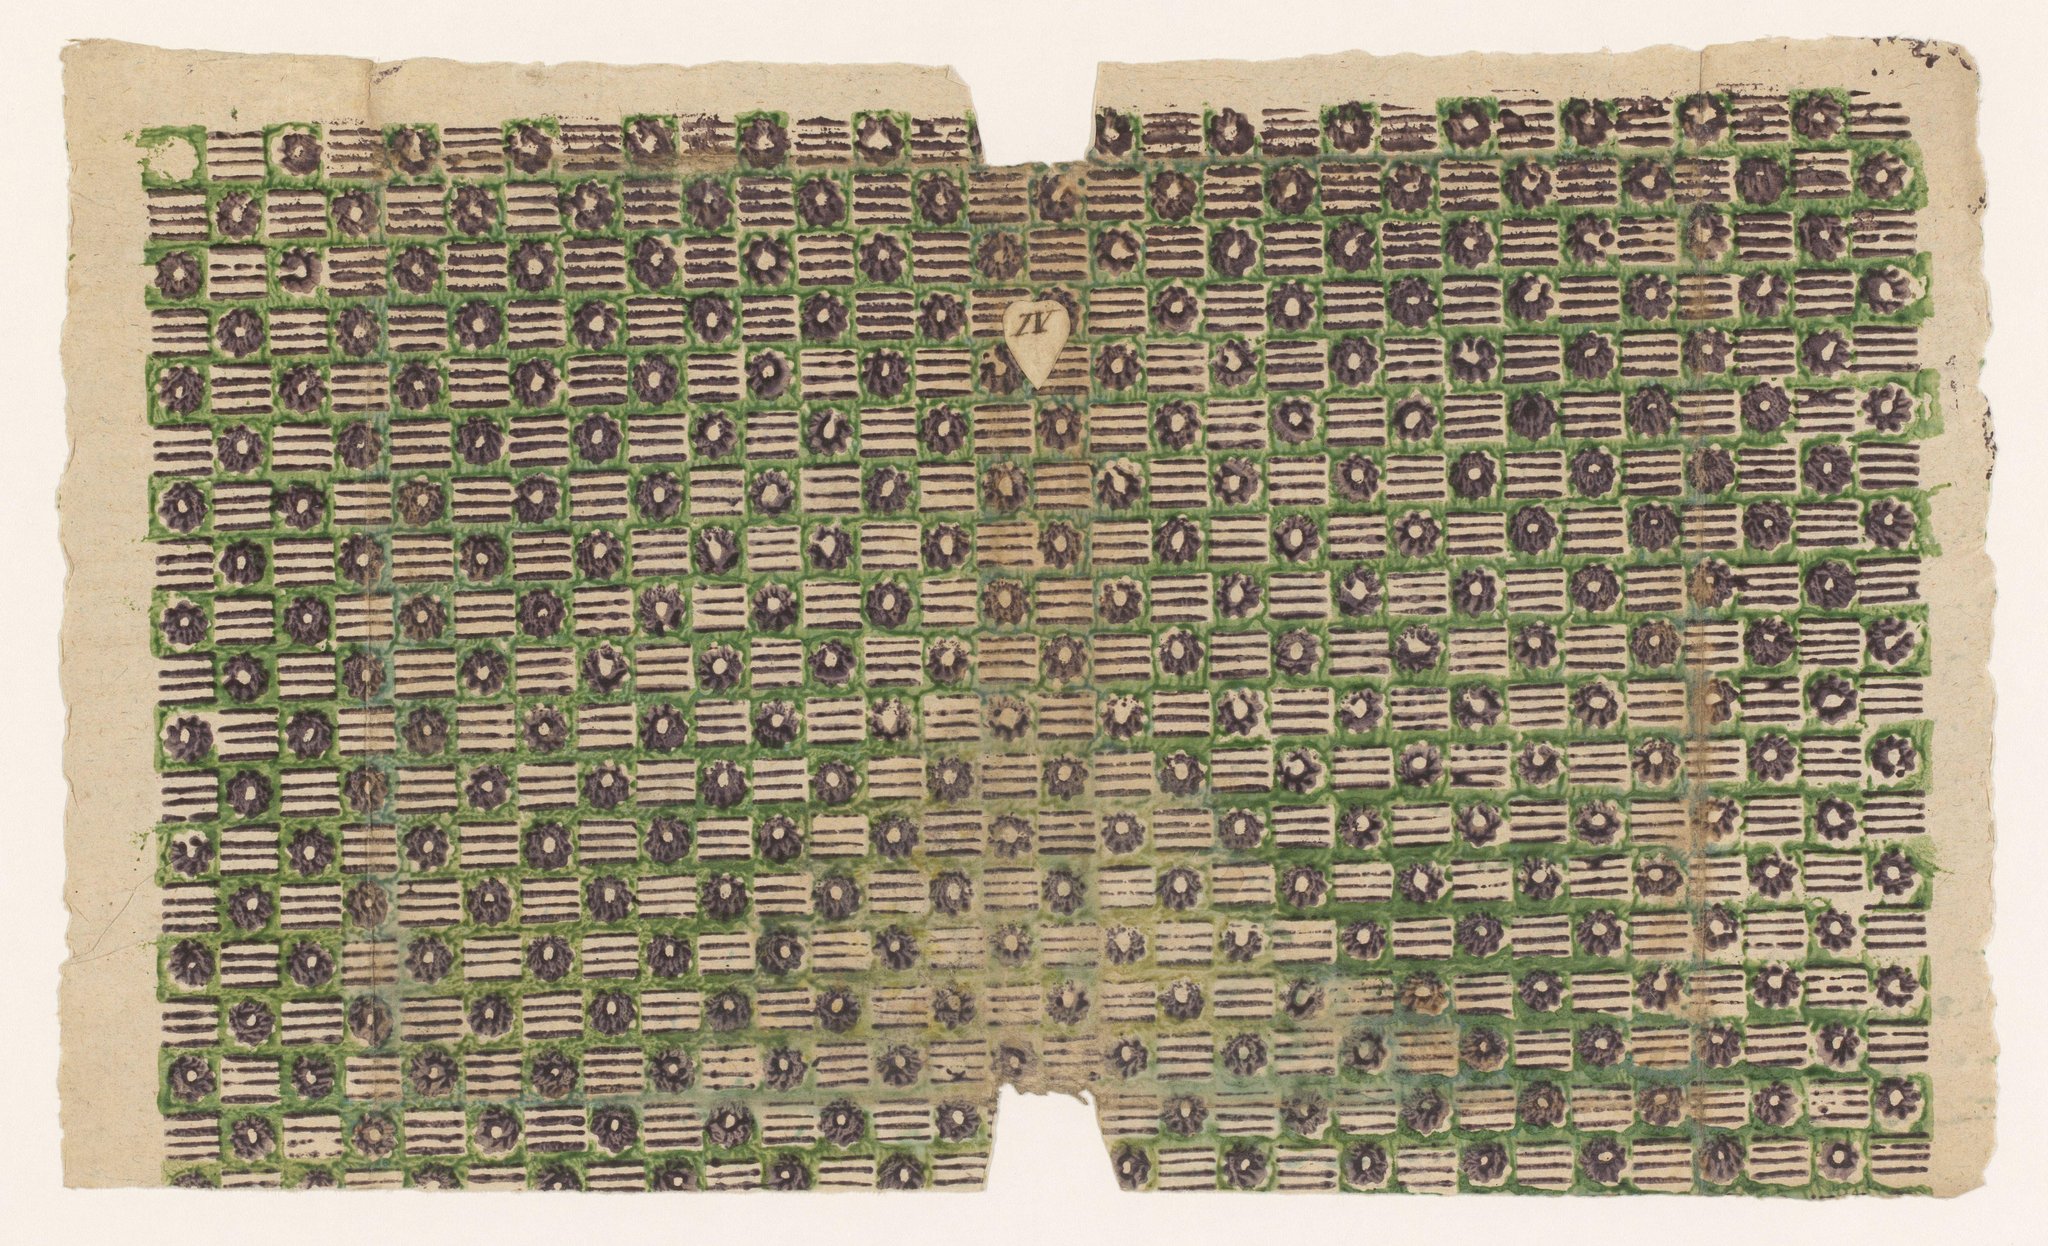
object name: wrapper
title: Blad met schaakbordpatroon van rozet en strepen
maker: Anonymous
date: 1750-1900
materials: paper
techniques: printing block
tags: ornament derived from plant forms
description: Blad met schaakbordpatroon van rozet en strepen. Gebruikt als omslag, met etiket.